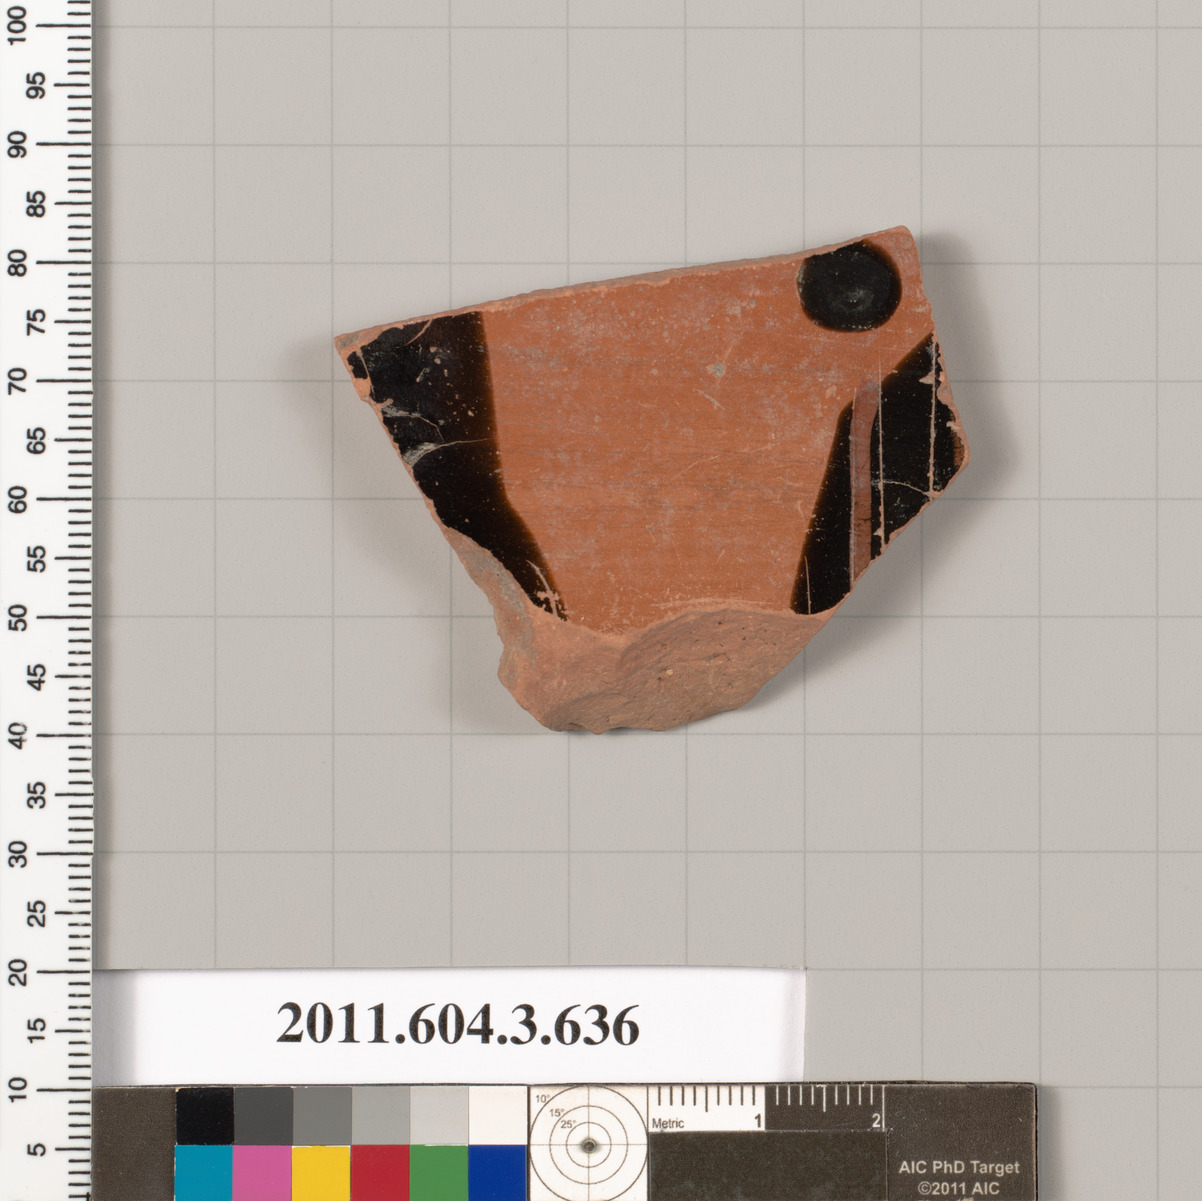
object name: calyx krater or column krater fragment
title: Terracotta fragment of a calyx-krater (bowl for mixing wine and water) or column-krater (bowl for mixing wine and water)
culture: greek, attic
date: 534-468 BCE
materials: terracotta